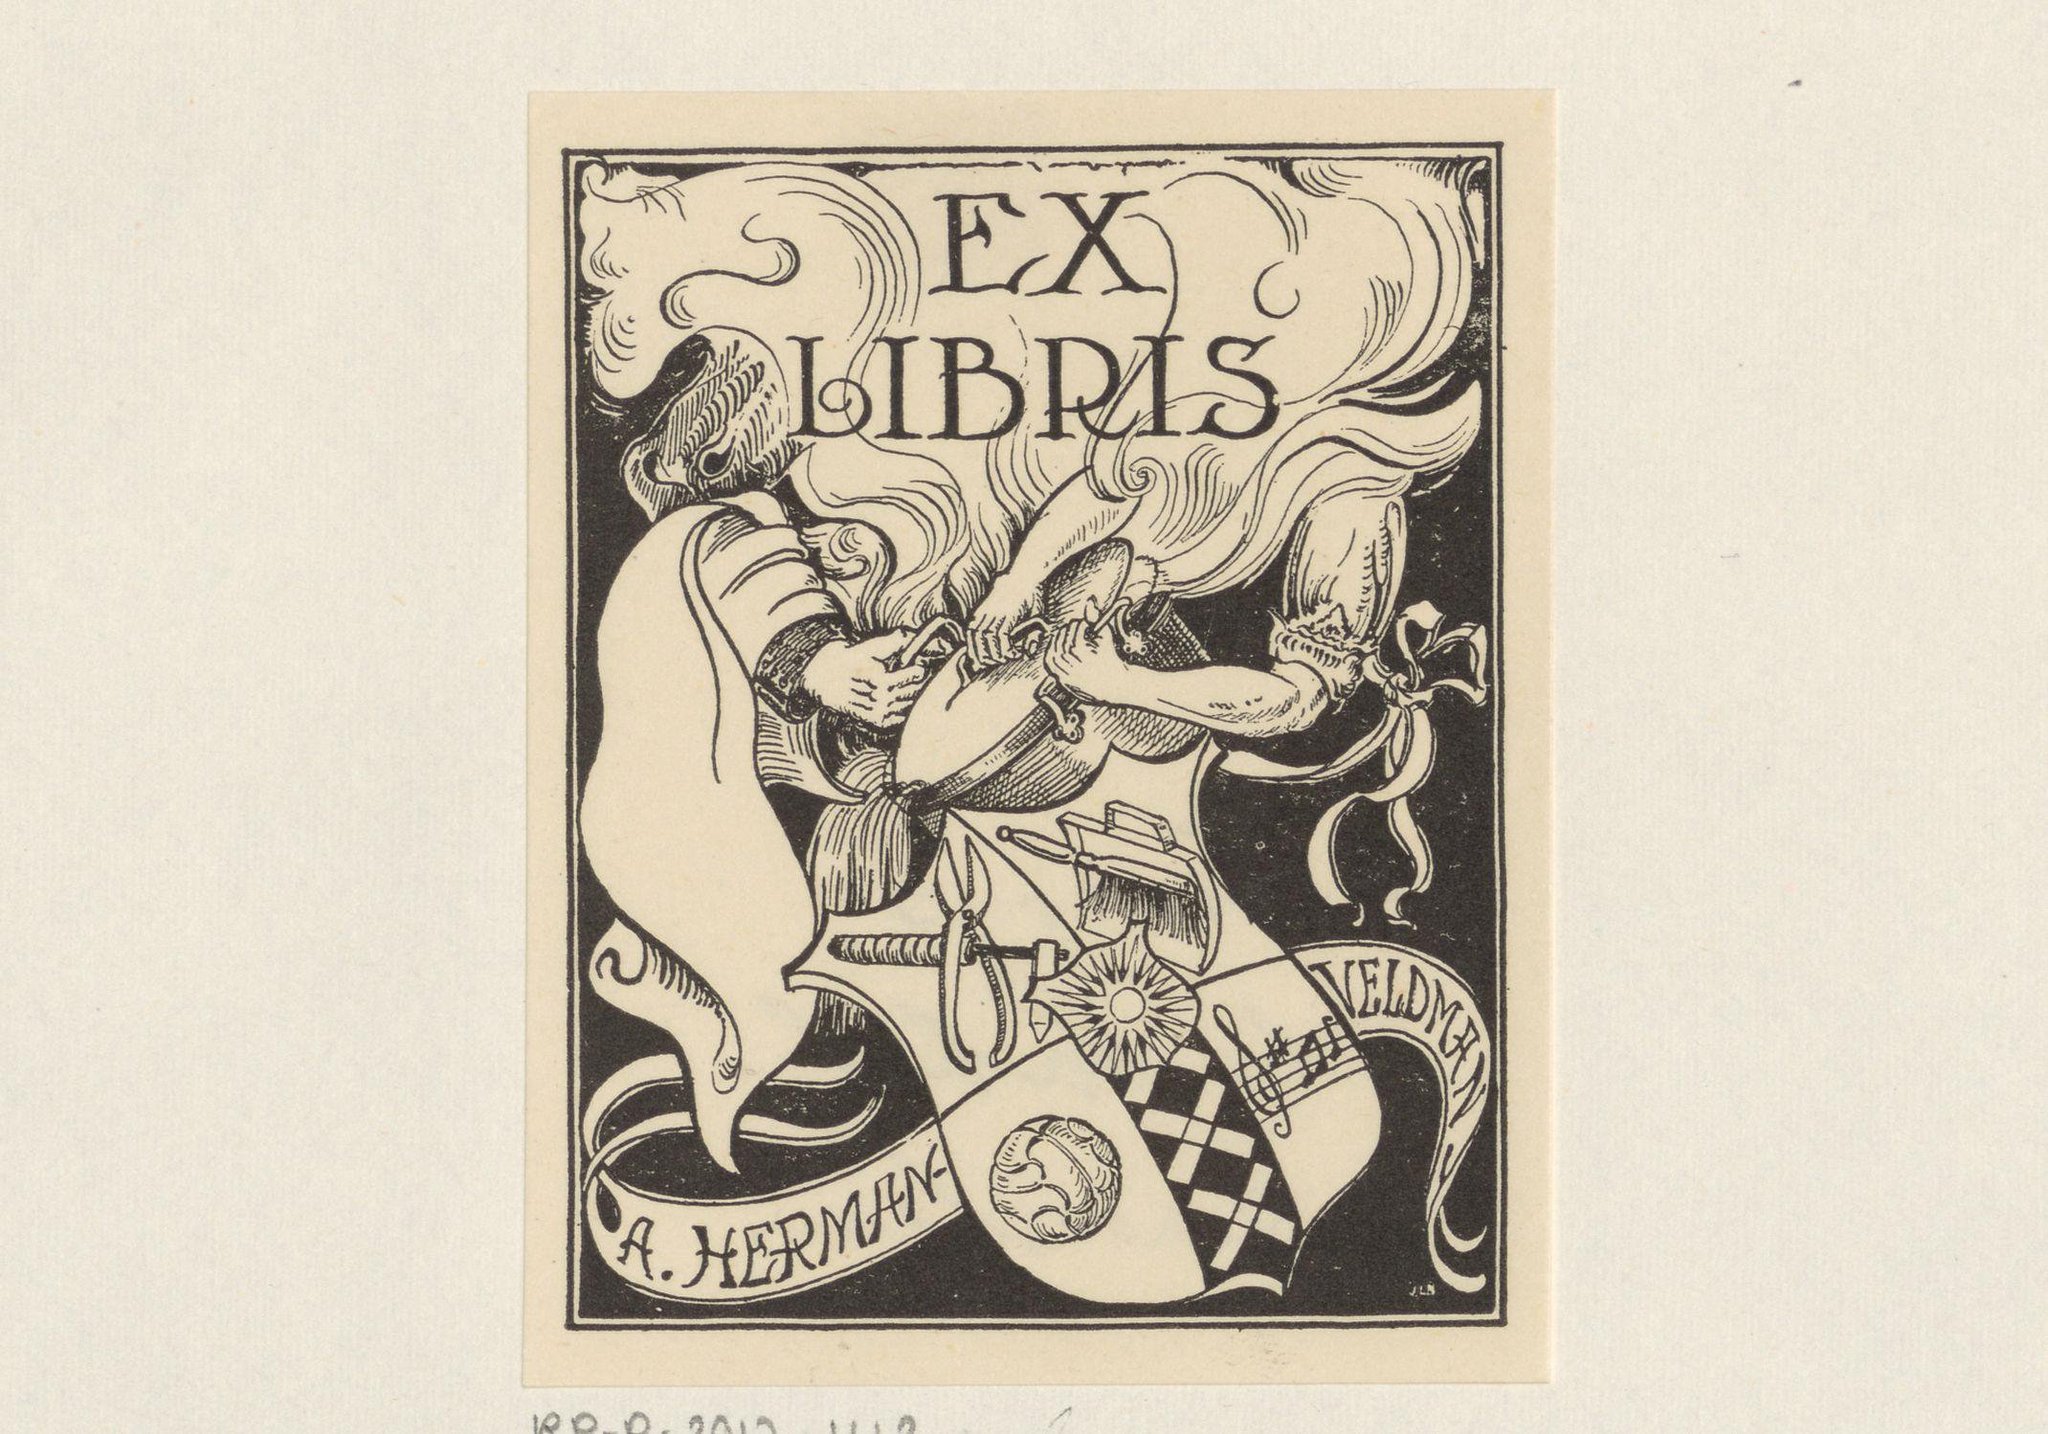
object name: bookplate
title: Ex libris van A. Herman Veldman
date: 1900-1999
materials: paper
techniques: printing block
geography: netherlands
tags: boring, drilling, piercing (industrial processes), notation of music, cooking food, armorial bearing, heraldry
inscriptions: inscription: ‘Ontwerp / J. le Nobel / Haarlem’